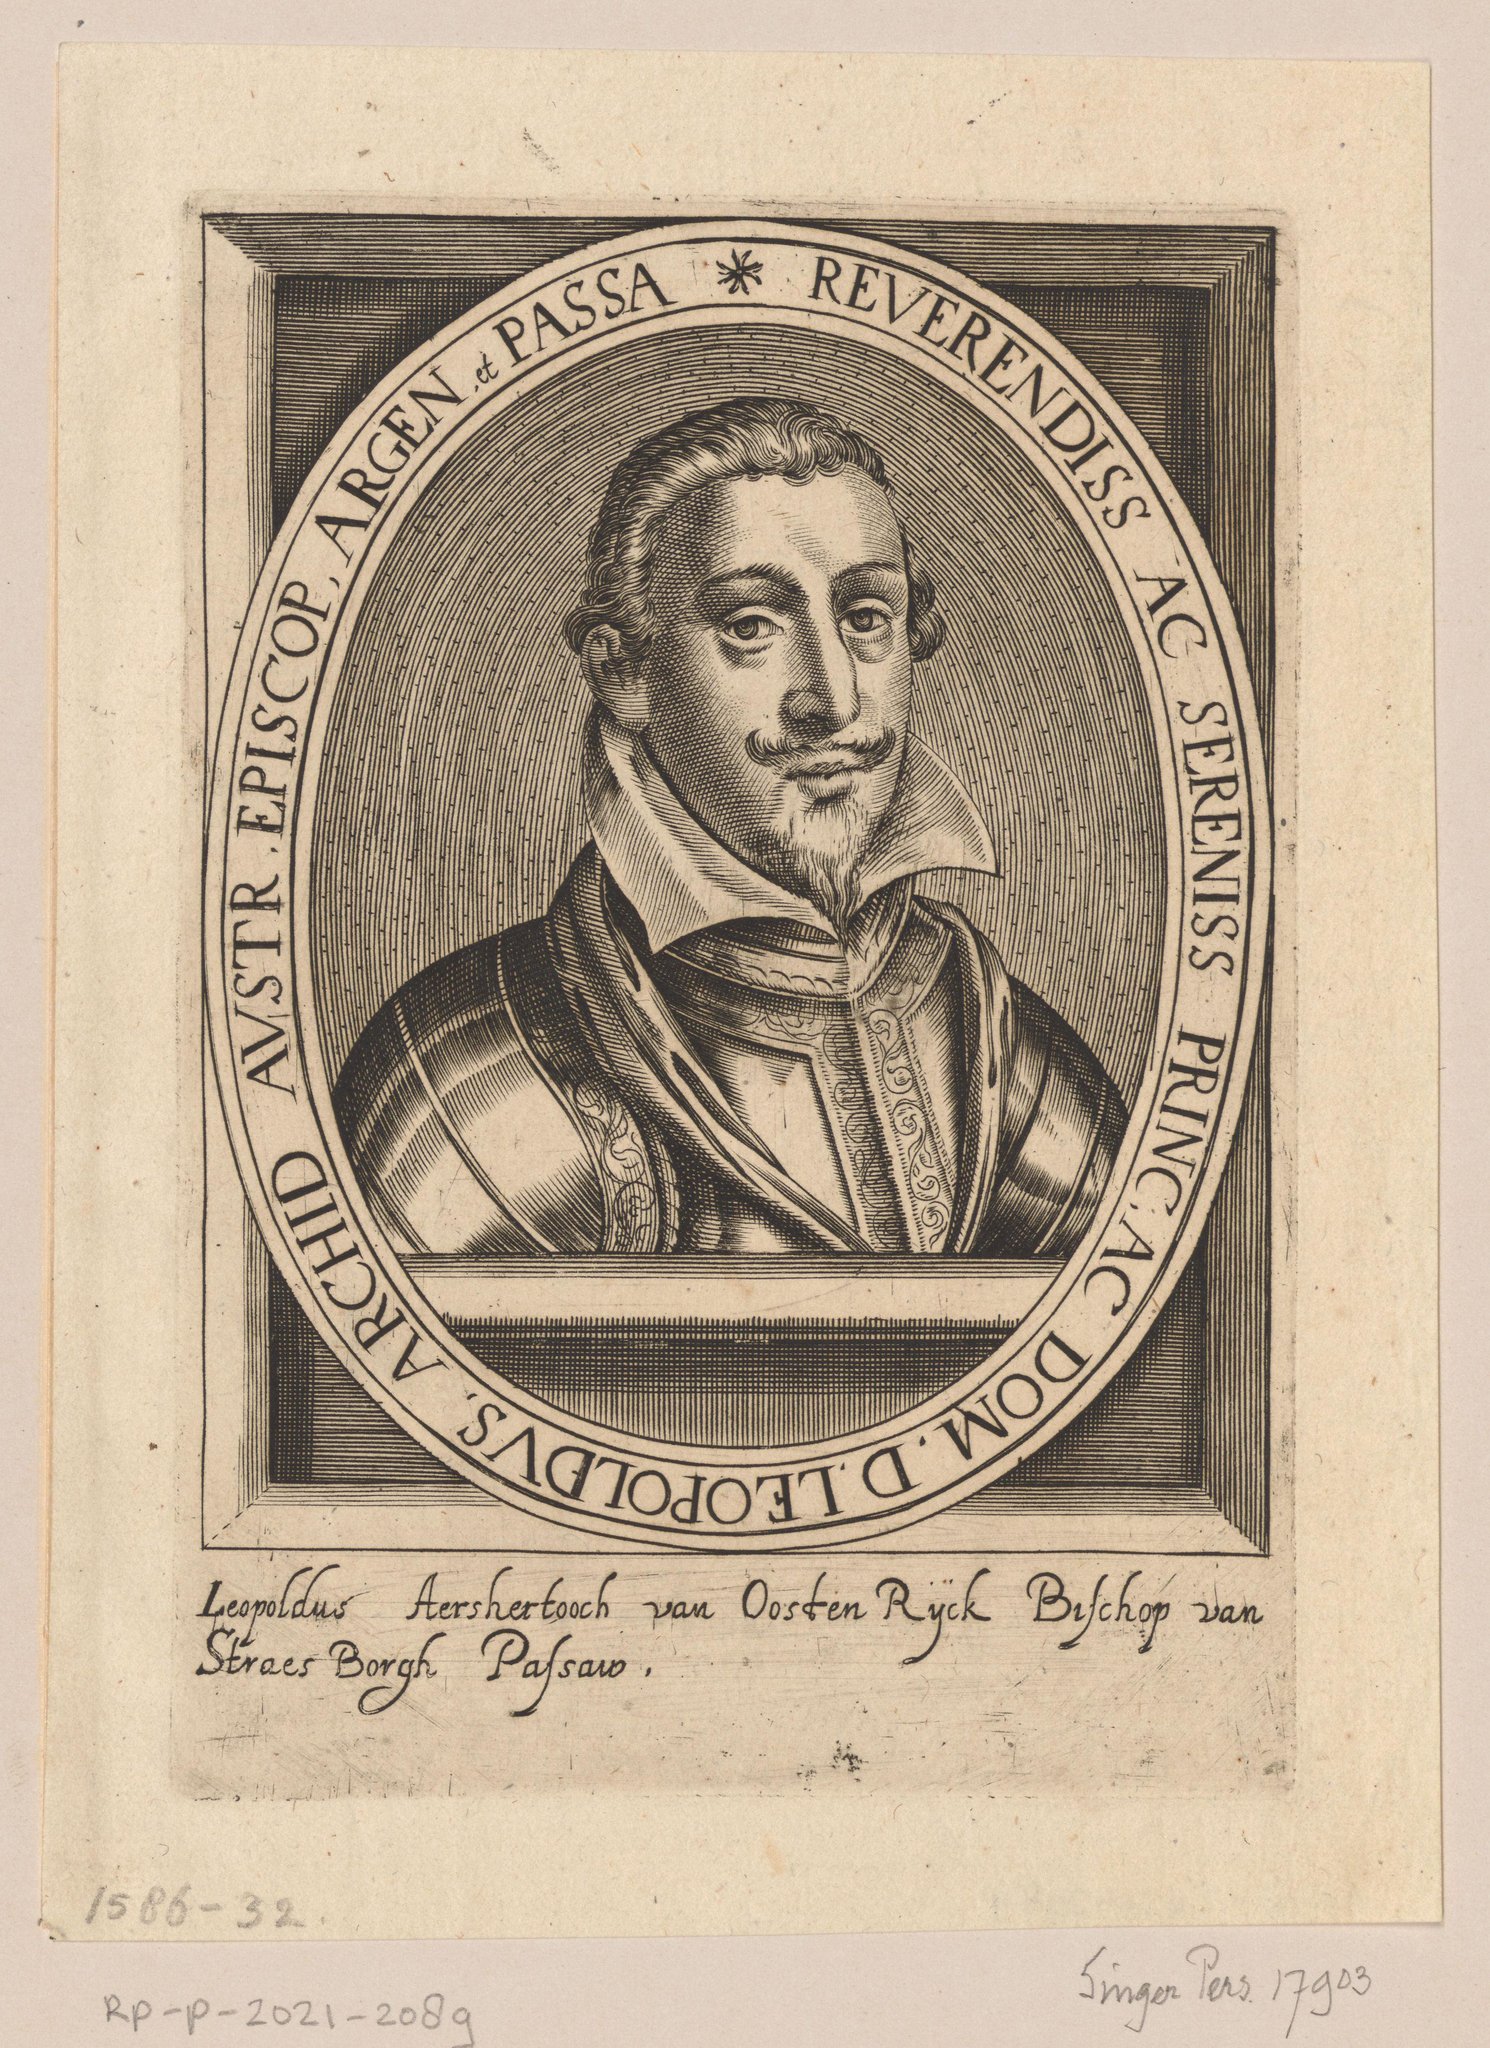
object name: print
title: Portret van Leopold V, aartshertog van Oostenrijk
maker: Anonymous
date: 1620-1699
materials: paper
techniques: engraving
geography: northern netherlands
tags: leopold v (aartshertog van oostenrijk), armour, historical persons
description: Met onderschrift in het Nederlands en tekst in het Latijn rondom het portret.